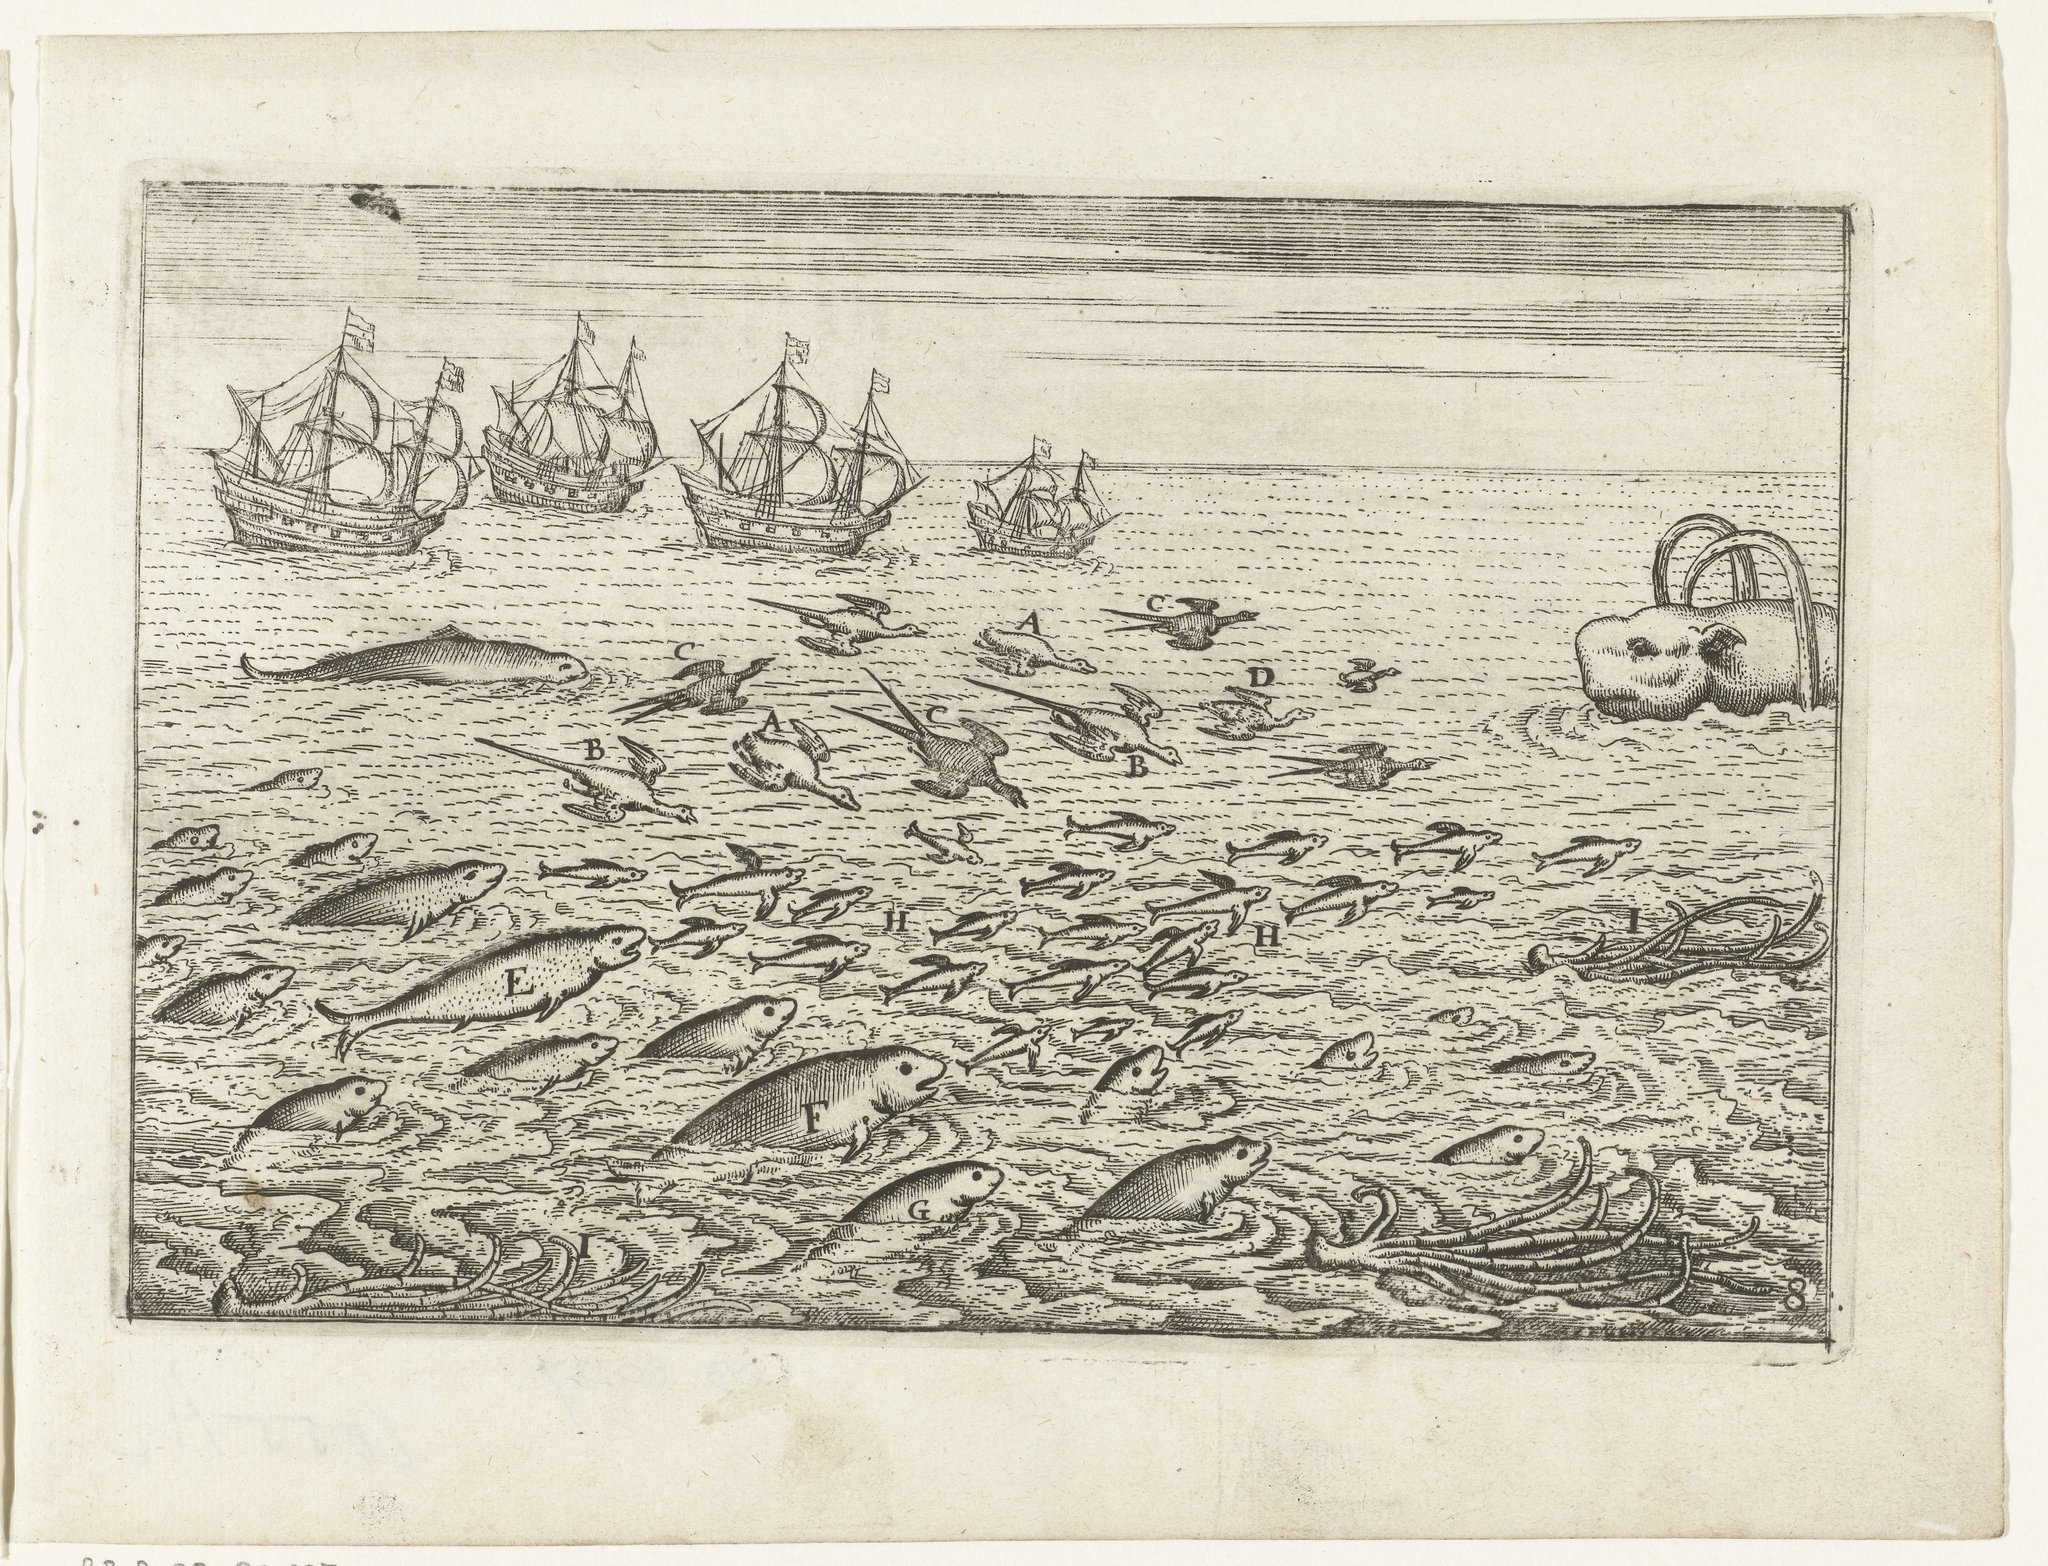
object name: print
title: Vliegende vissen, 1595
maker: Anonymous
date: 1597-1598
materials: paper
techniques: engraving, etching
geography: northern netherlands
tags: gouda, landscapes in tropical and sub-tropical regions, exploration, expedition, voyage of discovery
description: Gebruikt als illustratie eerst in: Willem Lodewijcksz, D'eerste boeck. Historie van Indien, waer inne verhaelt is de avontueren die de Hollandtsche schepen bejeghent zijn, Cornelis Claes, Amsterdam 1598. In deze opgewerkte staat gebruikt in: De Eerste Schipvaerd der Hollandsche Natie naer Oost-Indien, waer inne verhaelt wordt al wat haer sonderlings onder wegen bejegent is ... ghetrocken uyt verscheyden Iournalen ofte dagh-registers daer van ghemaeckt, zeer vermaeckelijck ende nut om lesen. Opgenomen in: I. Commelin, Begin ende voortgangh, van de Vereenighde Nederlantsche Geoctroyeerde Oost-Indische Compagnie, J. Janssonius, Amsterdam 1646. Genummerd: 8.